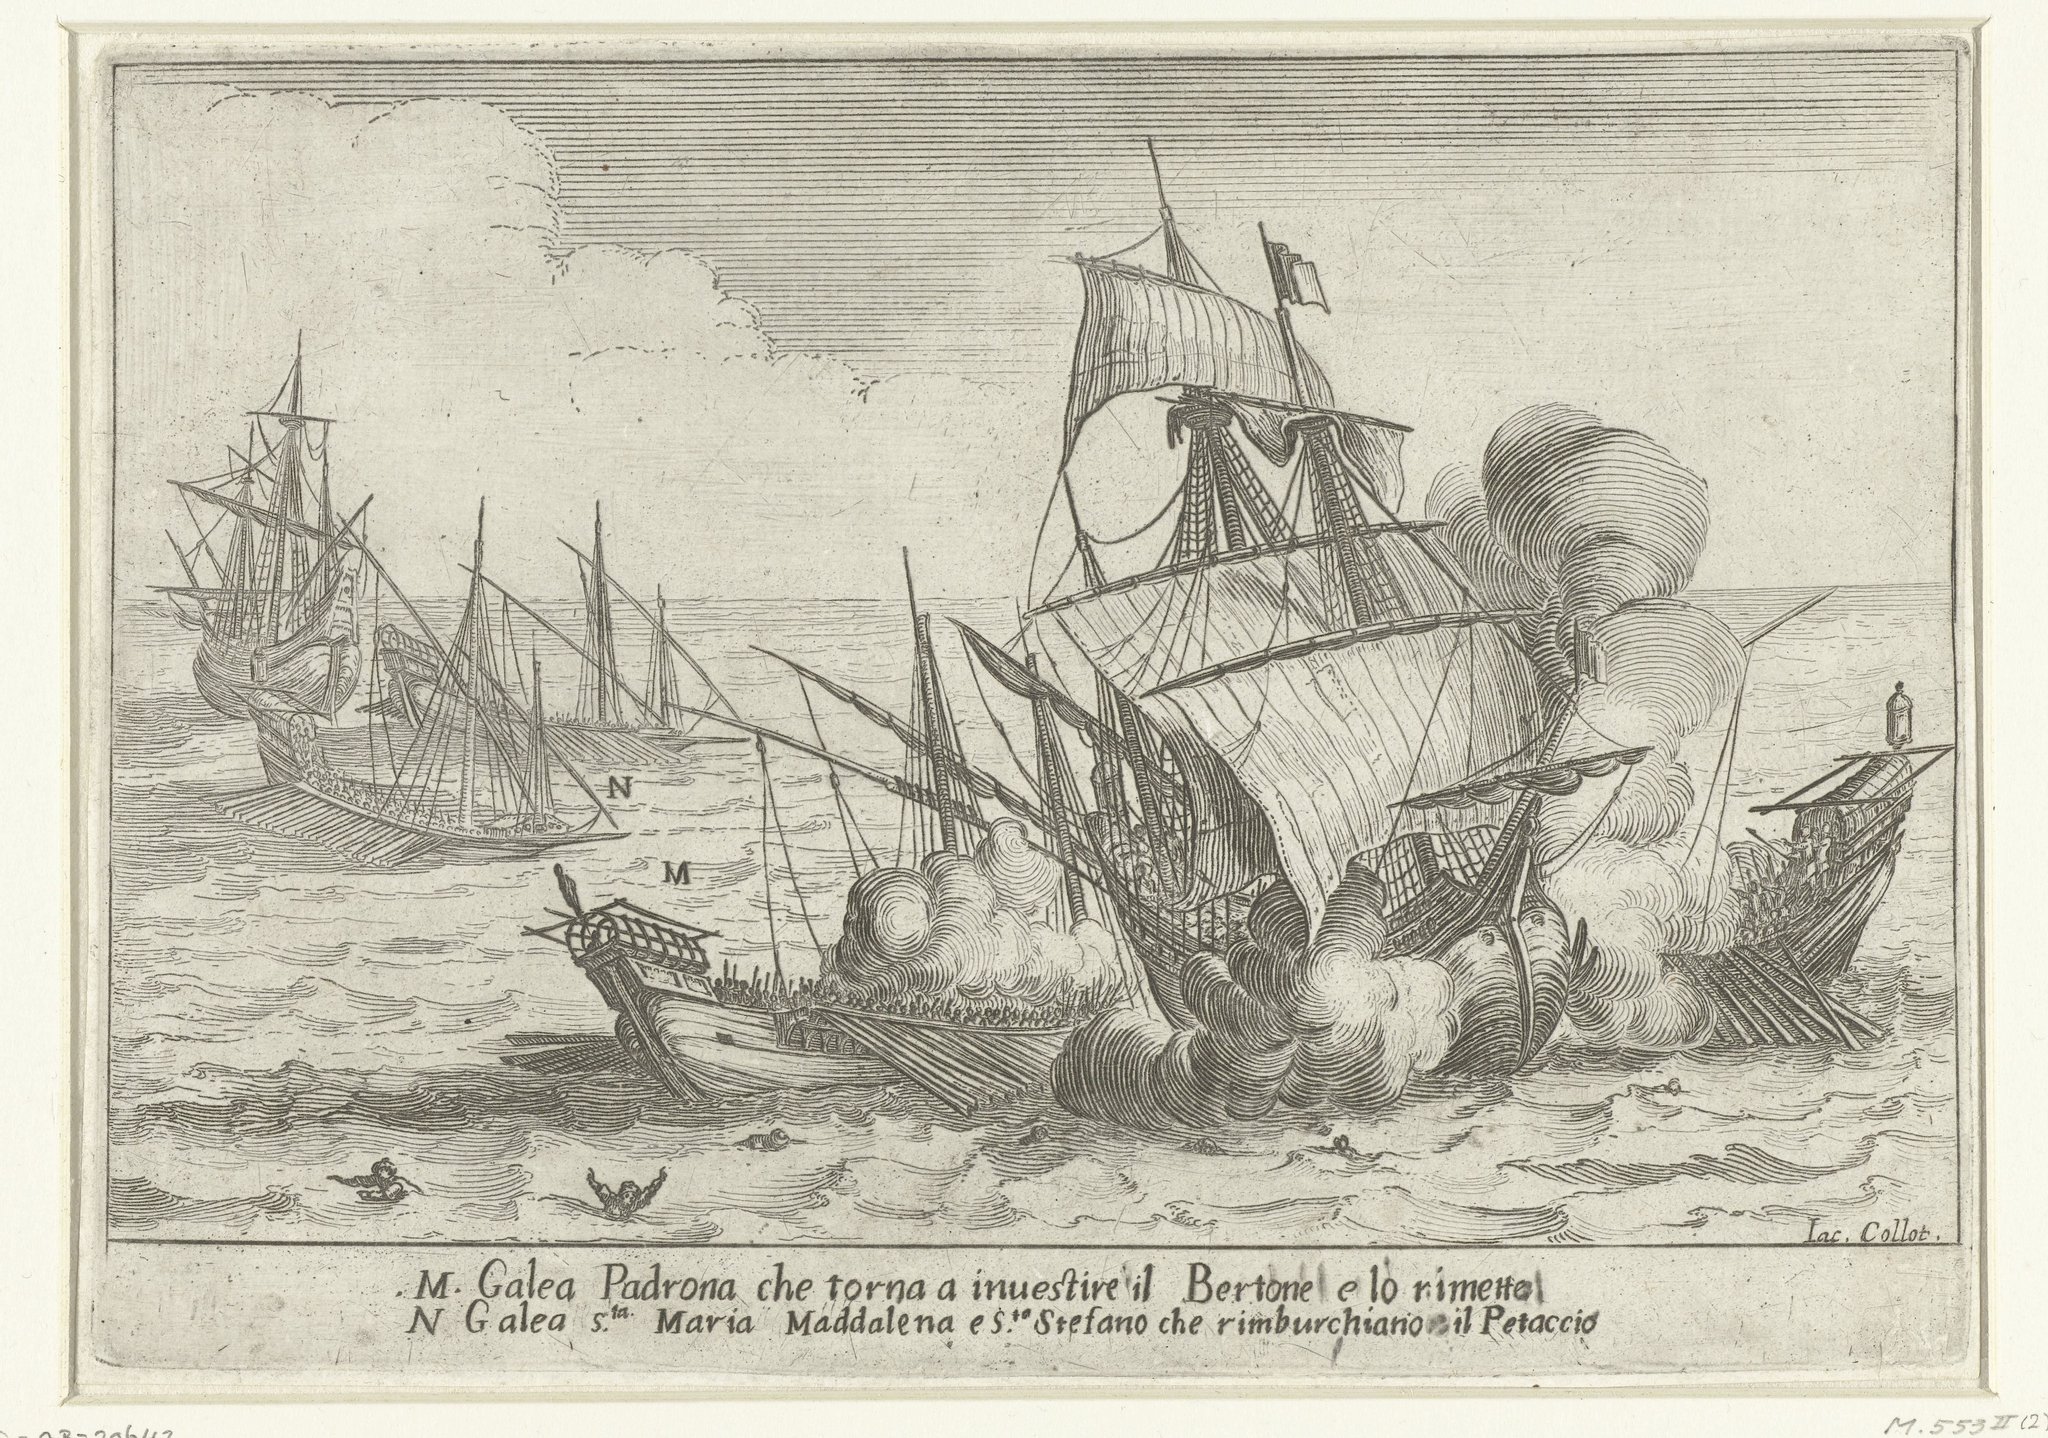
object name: print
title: Afloop van de strijd tussen galeien van Cosimo II de' Medici en de Turkse schepen 'Bertone' en 'Petaccio'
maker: jacques callot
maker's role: draughtsman, print maker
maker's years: 1592-1635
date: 1617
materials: paper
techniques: etching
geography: florence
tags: cosimo ii de' medici, battle, warfare; military affairs (+ sailing-ships), ships (in general)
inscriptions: collector's mark: Lugt 240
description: Op de voorgrond zijn twee galeien (van Cosimo II de' Medici) in een vuurgevecht verwikkeld met een (Turks) schip (de 'Bertone'). Op de achtergrond varen twee andere galeien (van Cosimo II de' Medici), met in hun kielzog een tweede (Turks) schip (de 'Petaccio'). Onder de voorstelling een verklarend onderschrift in het Italiaans. Deze prent is onderdeel van een serie van vier prenten die het verloop van de zeeslag tussen galeien van Cosimo II de' Medici en Turkse schepen op 23 november 1617 in de buurt van Corsica verbeelden, en die als illustraties bij een nieuwsbericht gediend hebben.